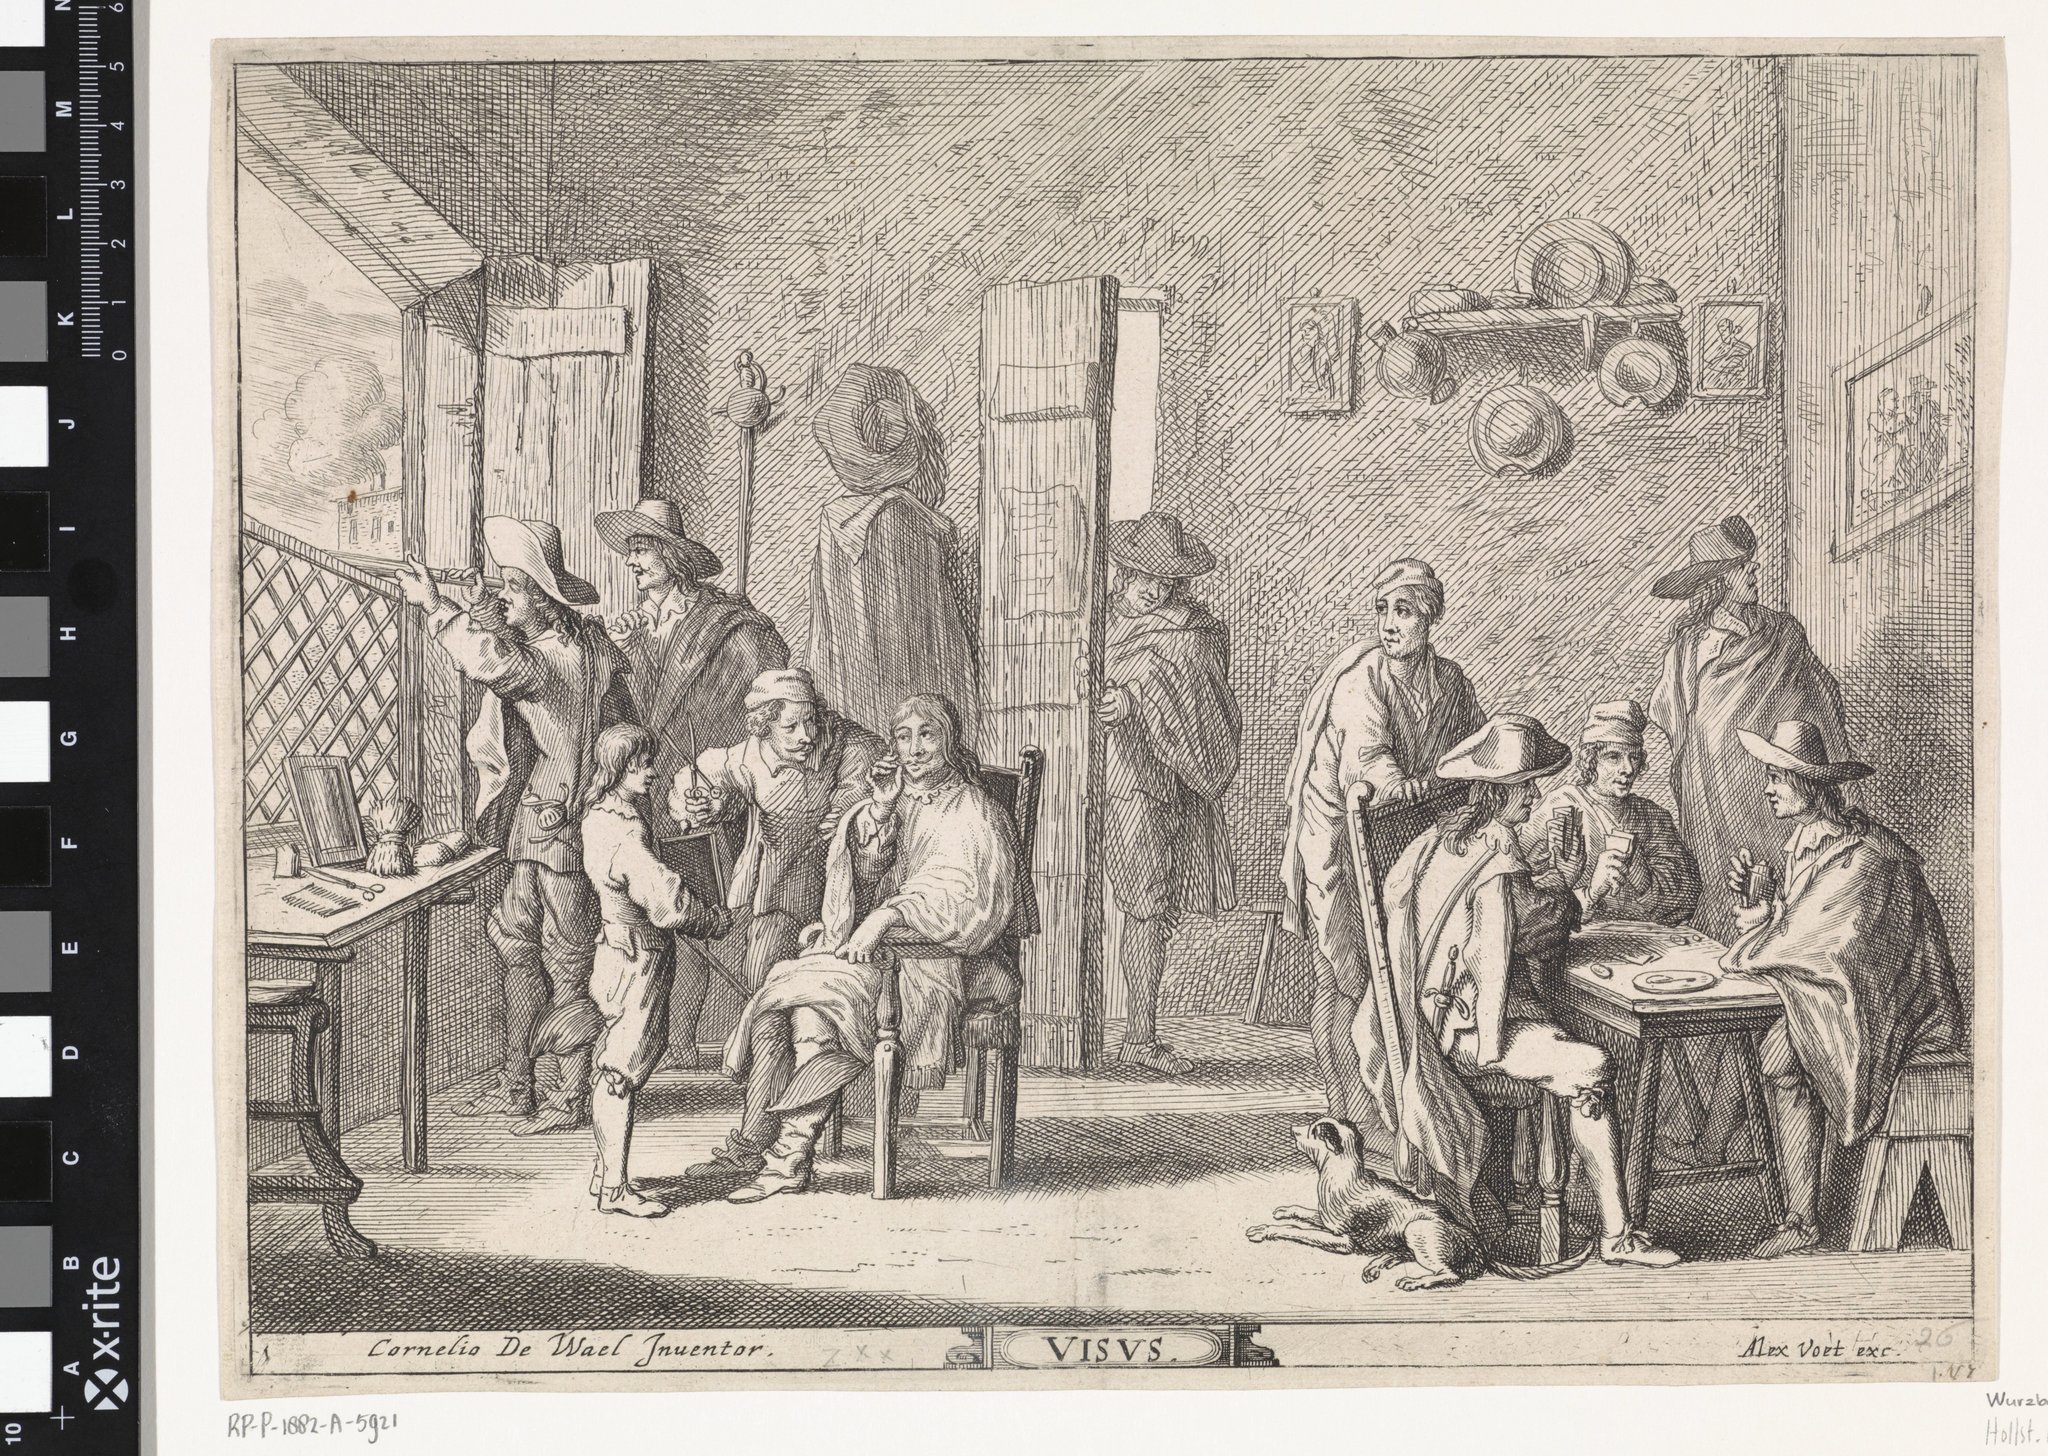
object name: print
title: Vijf zintuigen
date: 1628-1689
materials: paper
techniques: engraving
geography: italy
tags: sight, looking (one of the five senses)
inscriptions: collector's mark: Lugt 2228, number: ‘N.1’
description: Interieur van een herberg. Mannen rond een tafel spelen een kaartspel. Links houdt een jongen de spiegel op voor een barbier die de snor van een man bijknipt. Een andere man kijkt door een telescoop naar buiten. Door de deur komt een man de herberg binnen.